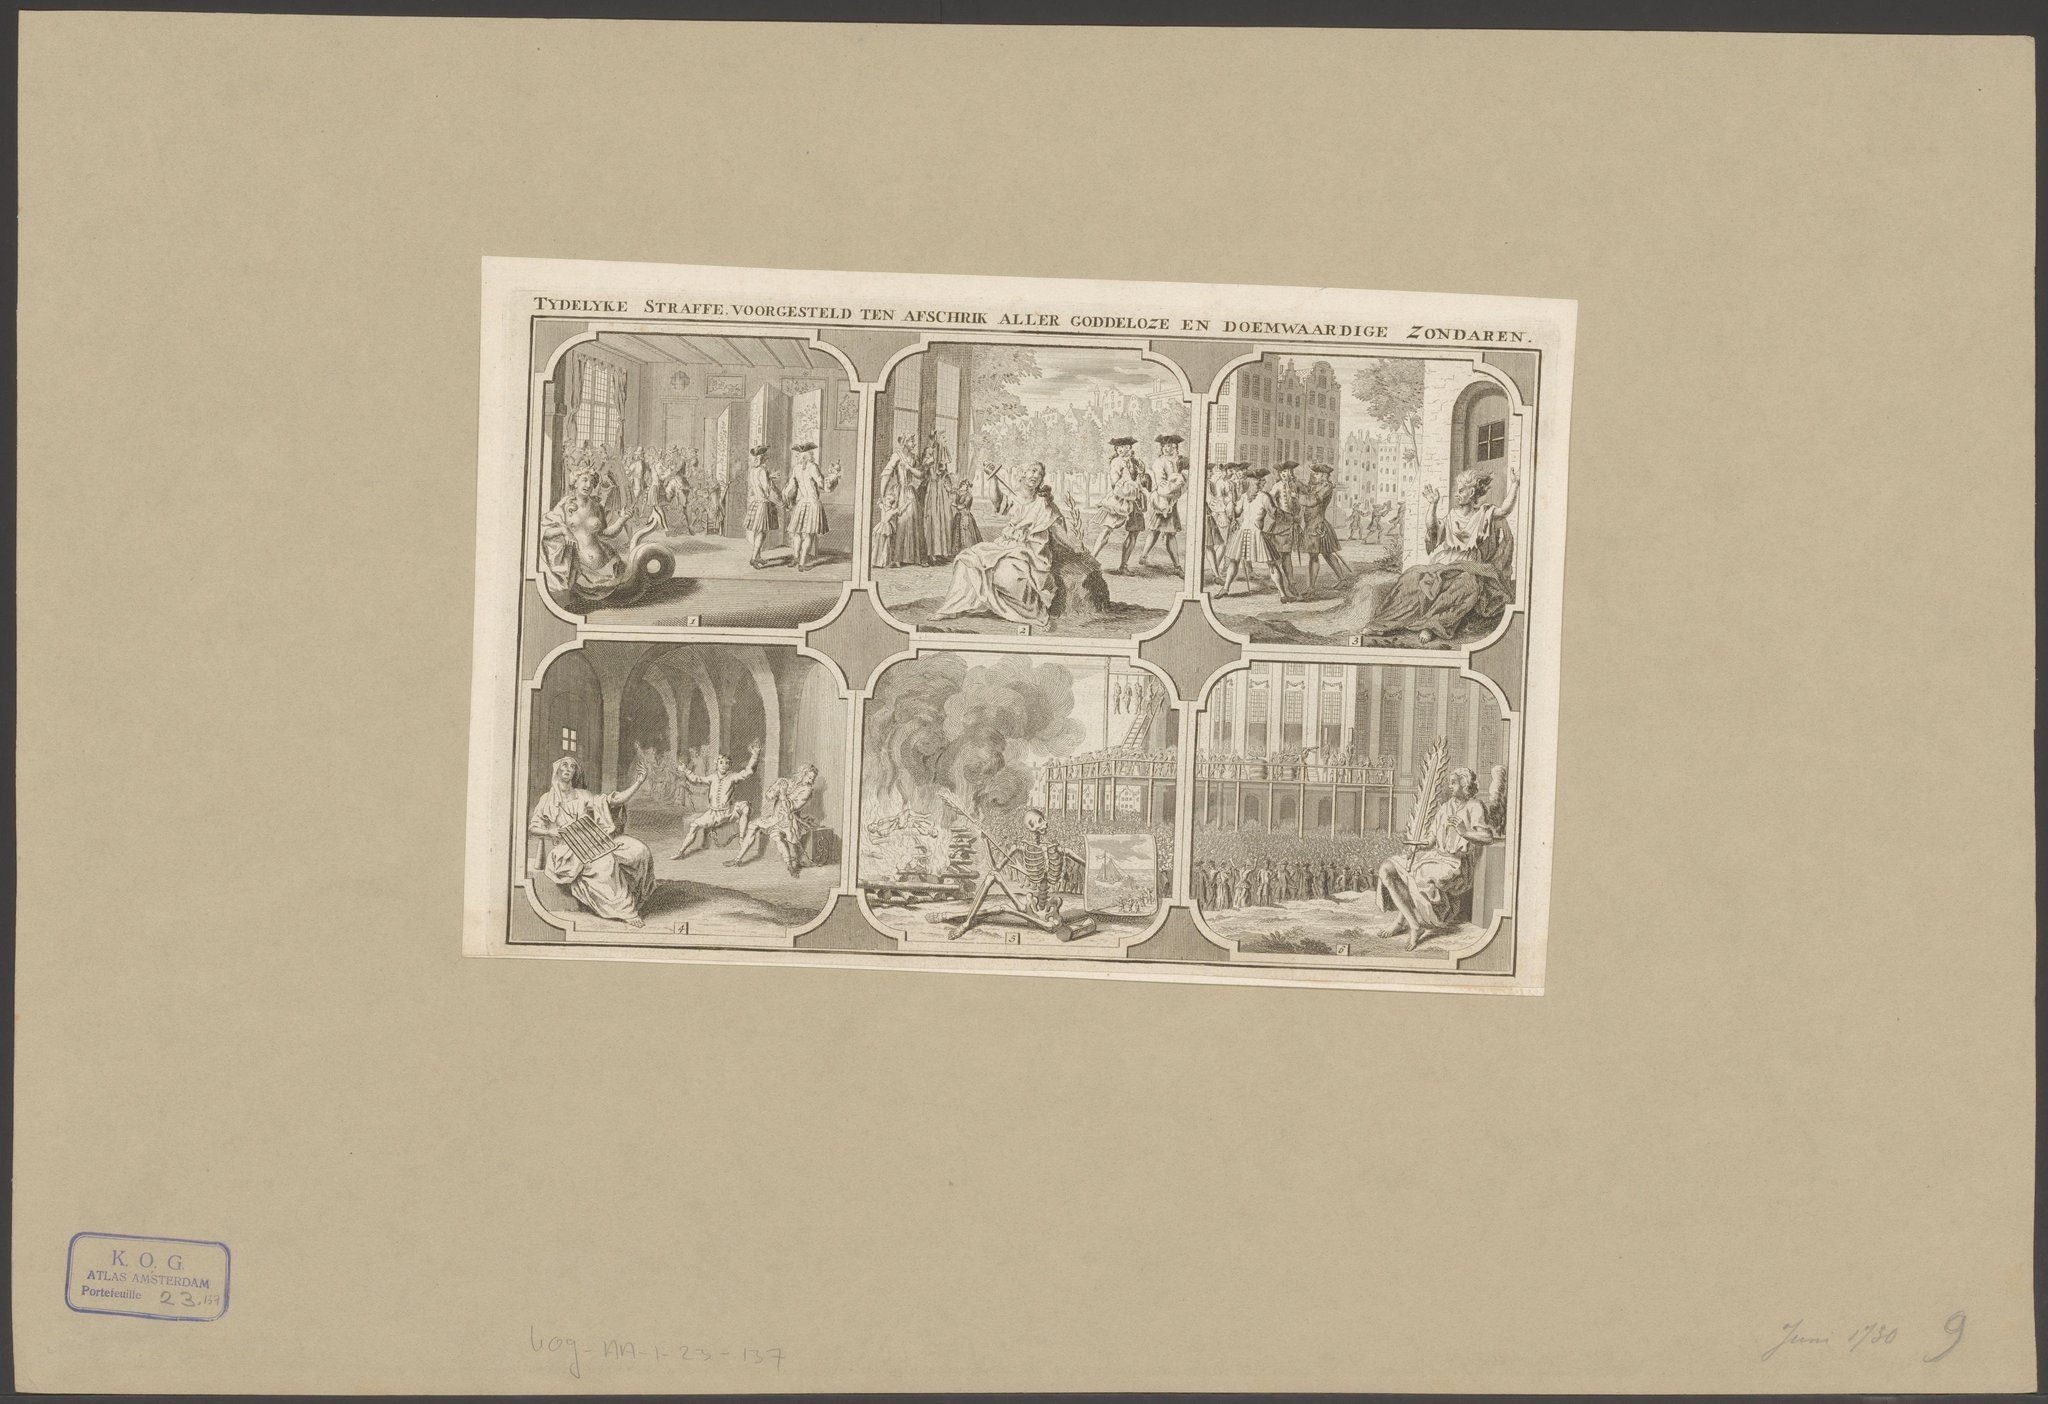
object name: print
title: Vervolgen en straffen van homoseksuelen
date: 1730-1731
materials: paper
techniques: etching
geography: northern netherlands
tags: sodomy, sexual contact between men, law and jurisprudence (+ public punishment), law and jurisprudence (+ imprisonment), violent death by hanging, drowning (violent death ~ water), man as sinner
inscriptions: collector's mark: Lugt 1641b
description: Prent mogelijk uit: Schouw-tooneel soo der geëxecuteerde als ingedaagde over de verfoeilyke misdaad van sodomie (...). S.l.s.n., 1730. Of uit: Alle de copyen van indagingen, als mede alle de gedichten op de tegenwoordige tyd toepasselyk. S.l.s.n., [1731].